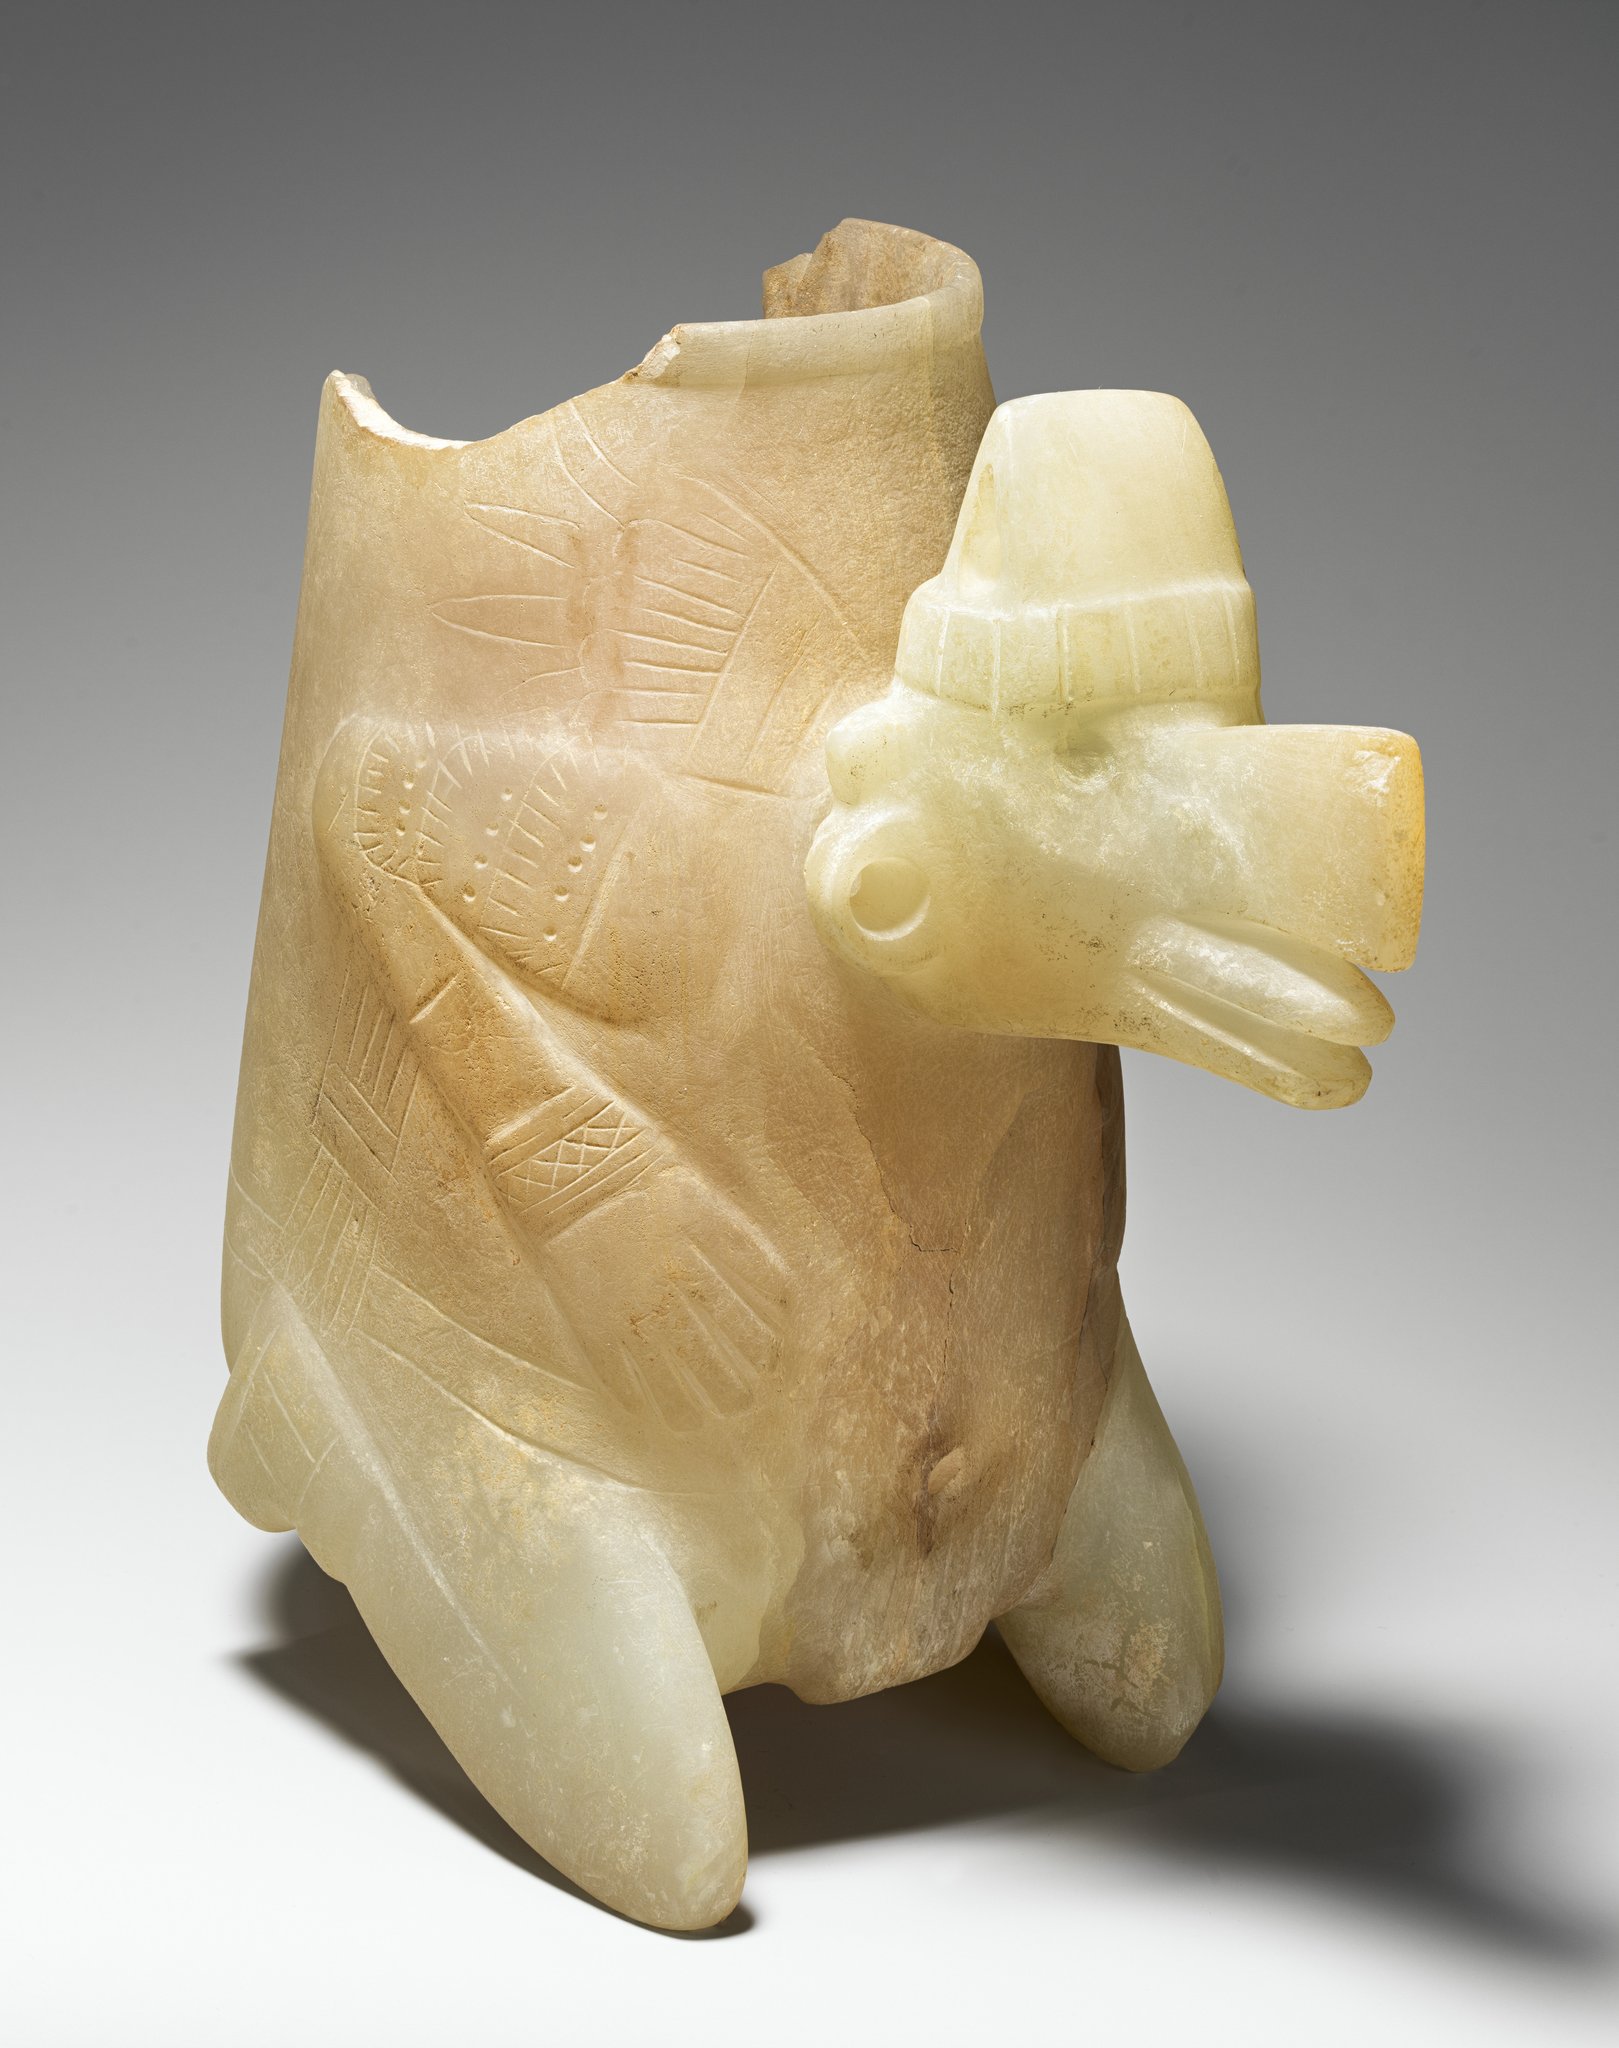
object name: vessel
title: Ehecatl (wind deity) vessel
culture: mixtec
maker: mixtec (ñuu savi) artists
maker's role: artist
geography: mexico